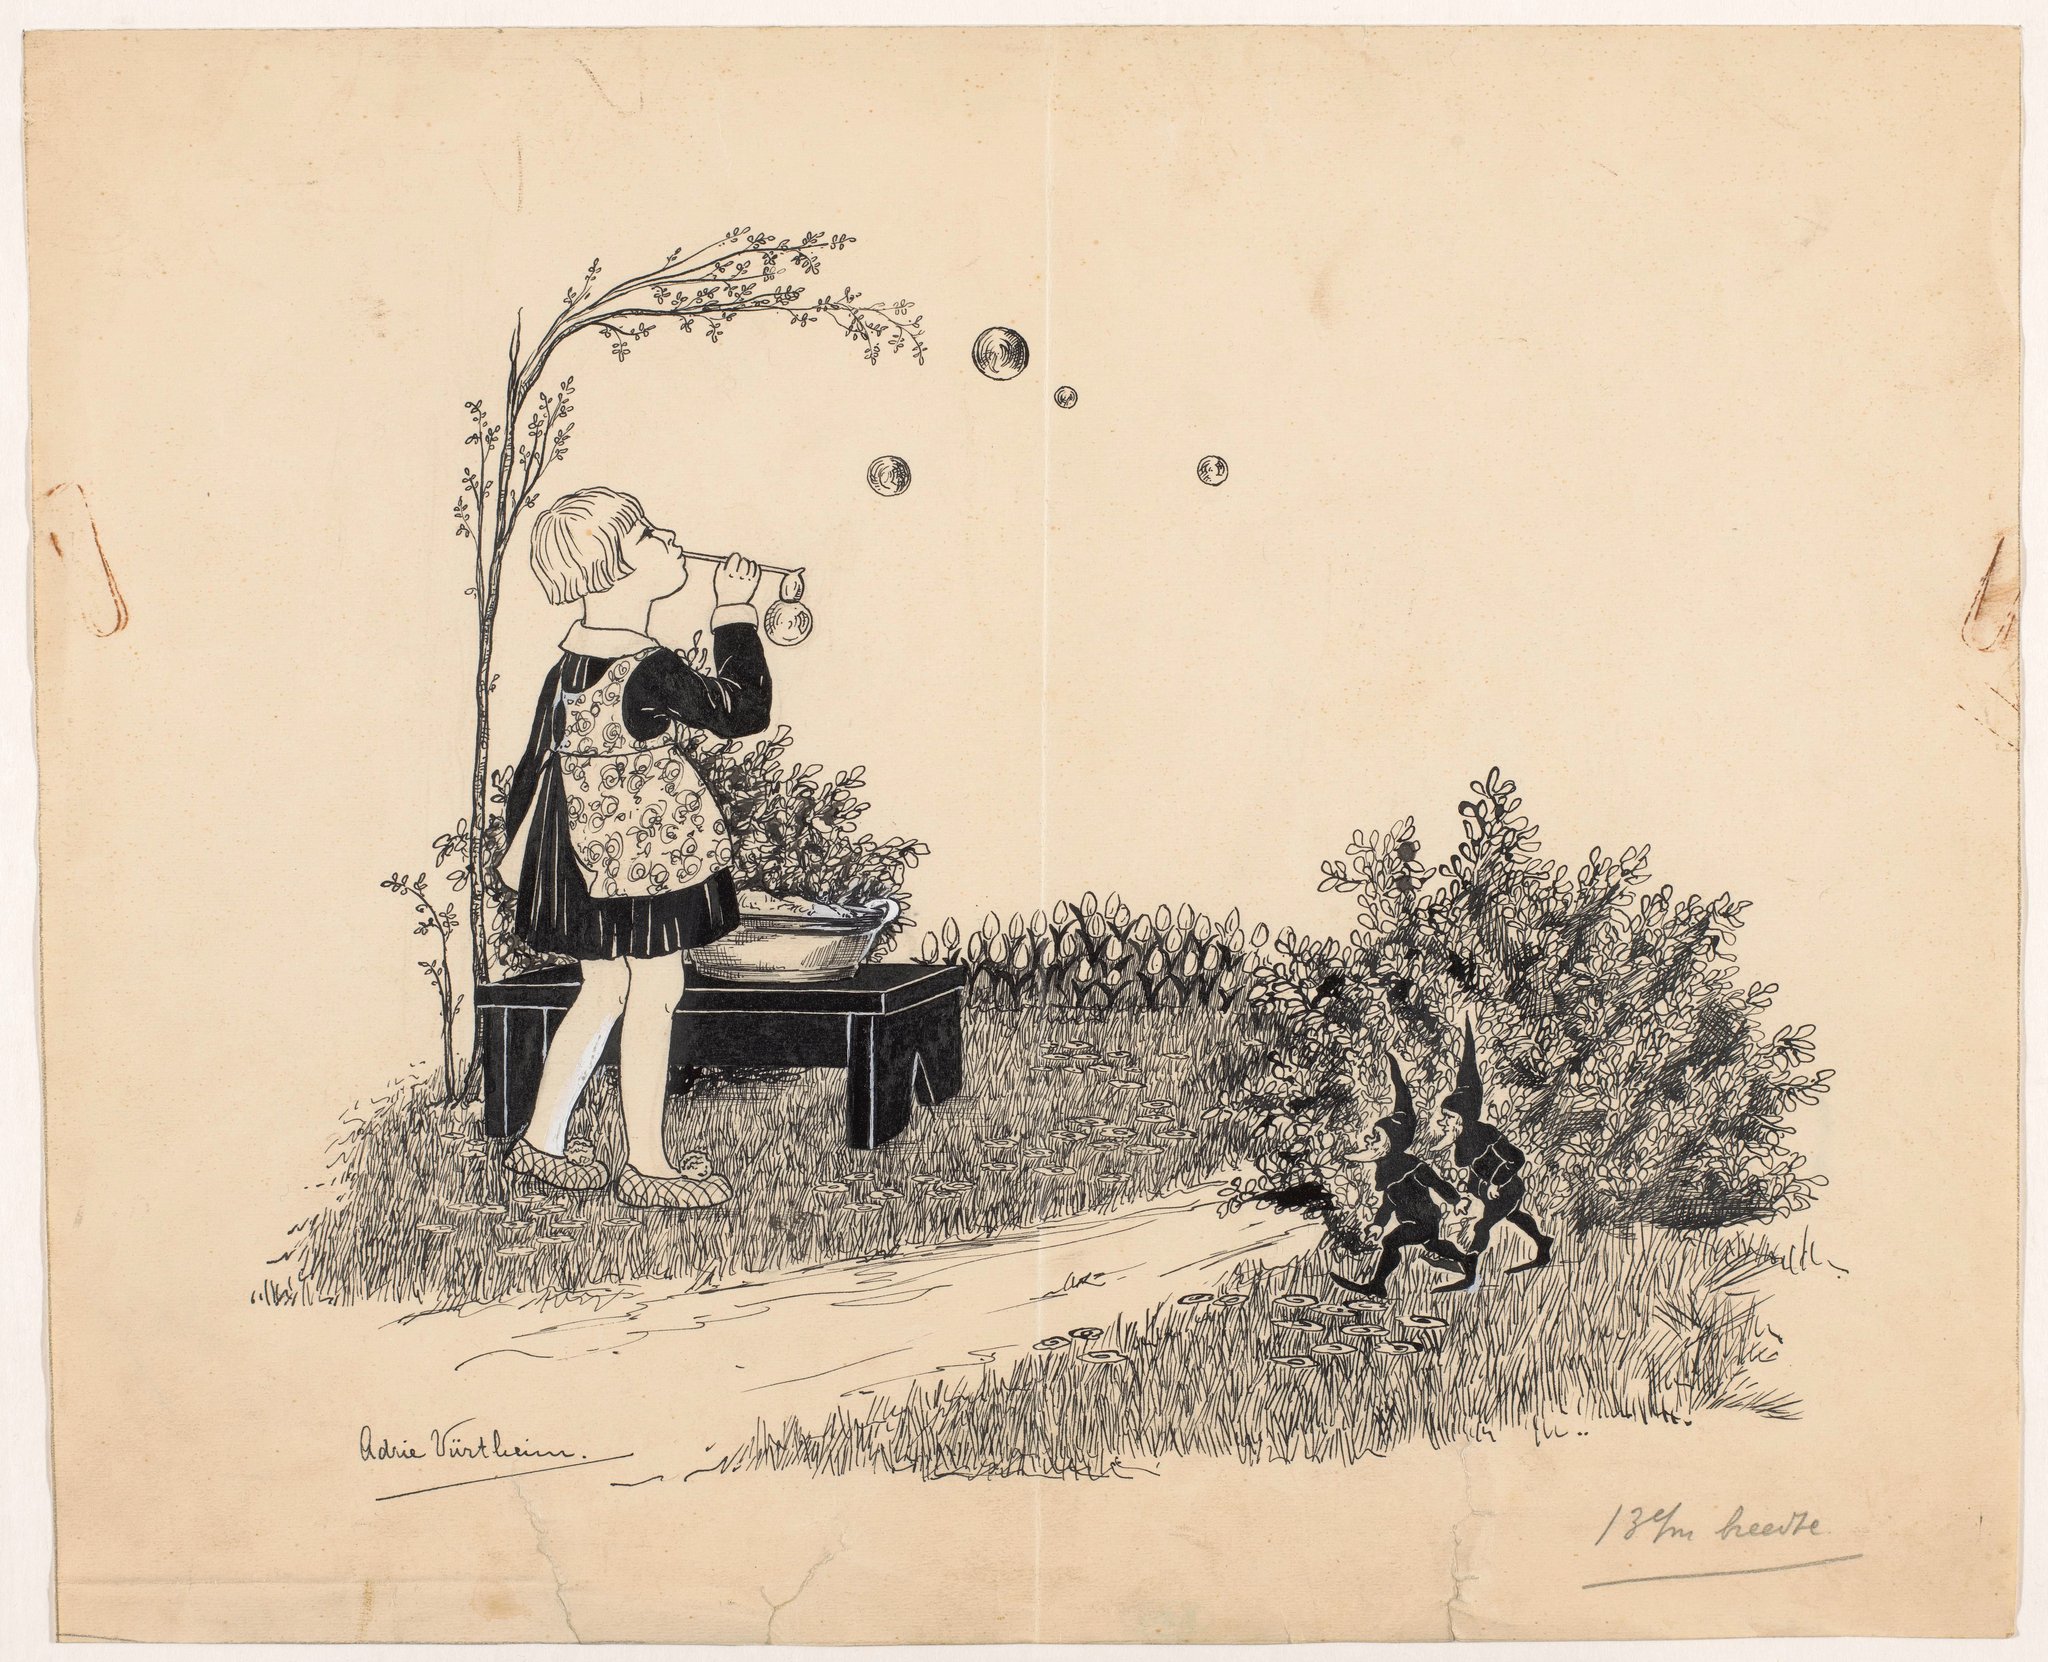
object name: drawing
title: Bellenblazend meisje en twee kabouters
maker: adrie vürtheim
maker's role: draughtsman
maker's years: 1907-1995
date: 1917-1970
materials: paint, ink, paper, pencil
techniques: brush, pen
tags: bubble-blowing (children's games and plays), spirit of the earth, gnome, troll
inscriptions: :, signature: ‘Adrie Vürtheim.’, collector's mark: Lugt 2228a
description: Een meisje staat langs een pad bellen te blazen met een rietje. Naast haar staat een ton met zeepsop op een tafel. Bij een struik aan de overkant van het pad komen twee kabouters aanlopen.